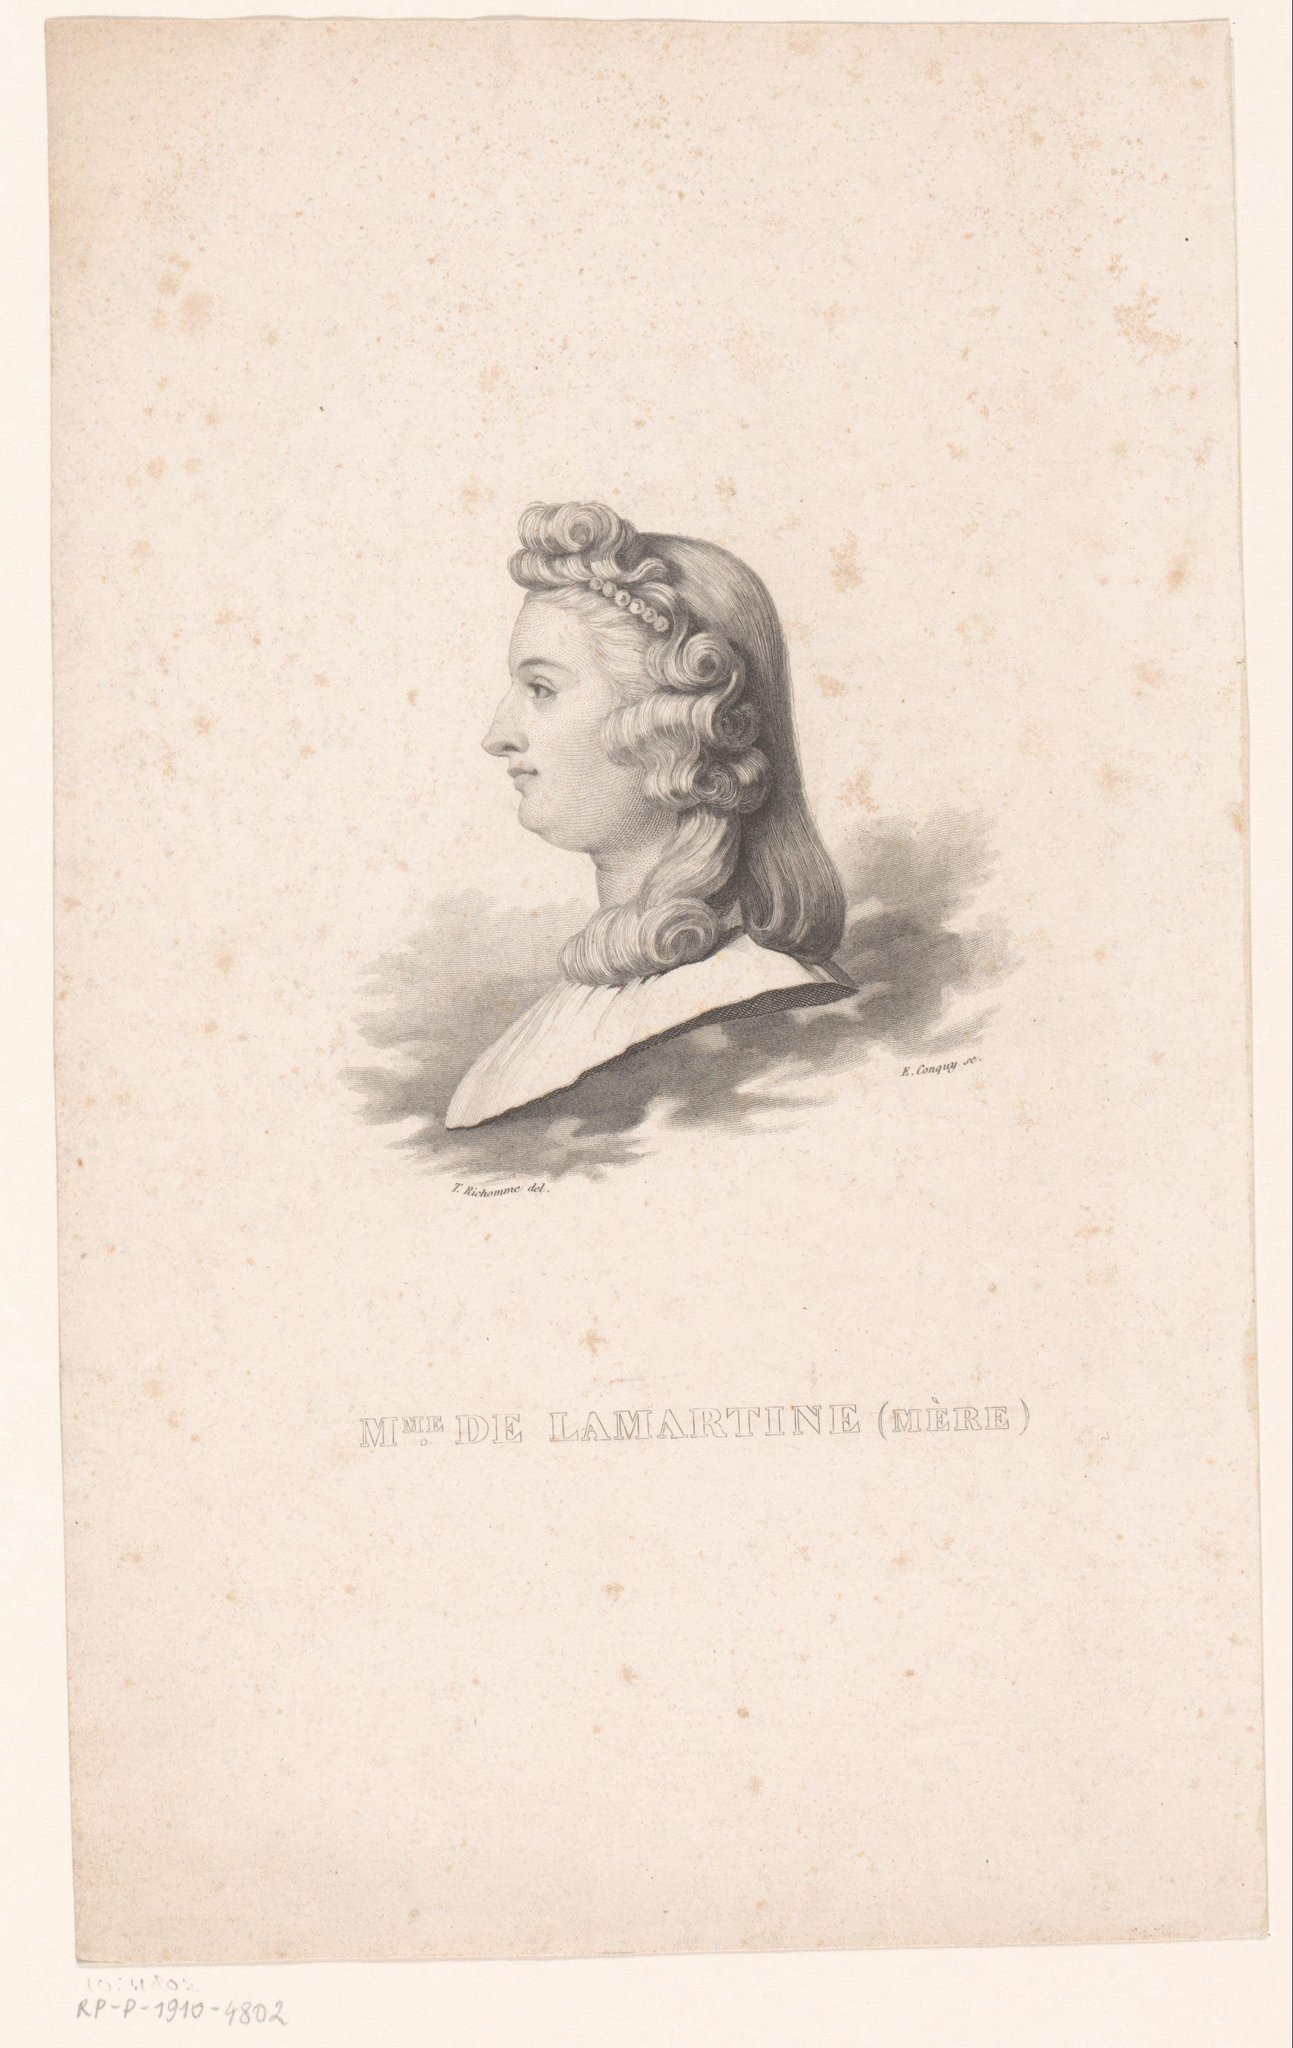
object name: print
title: Portret van Alix de Lamartine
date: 1819-1843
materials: paper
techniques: engraving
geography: france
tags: portrait of a writer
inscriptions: collector's mark: Lugt 2228